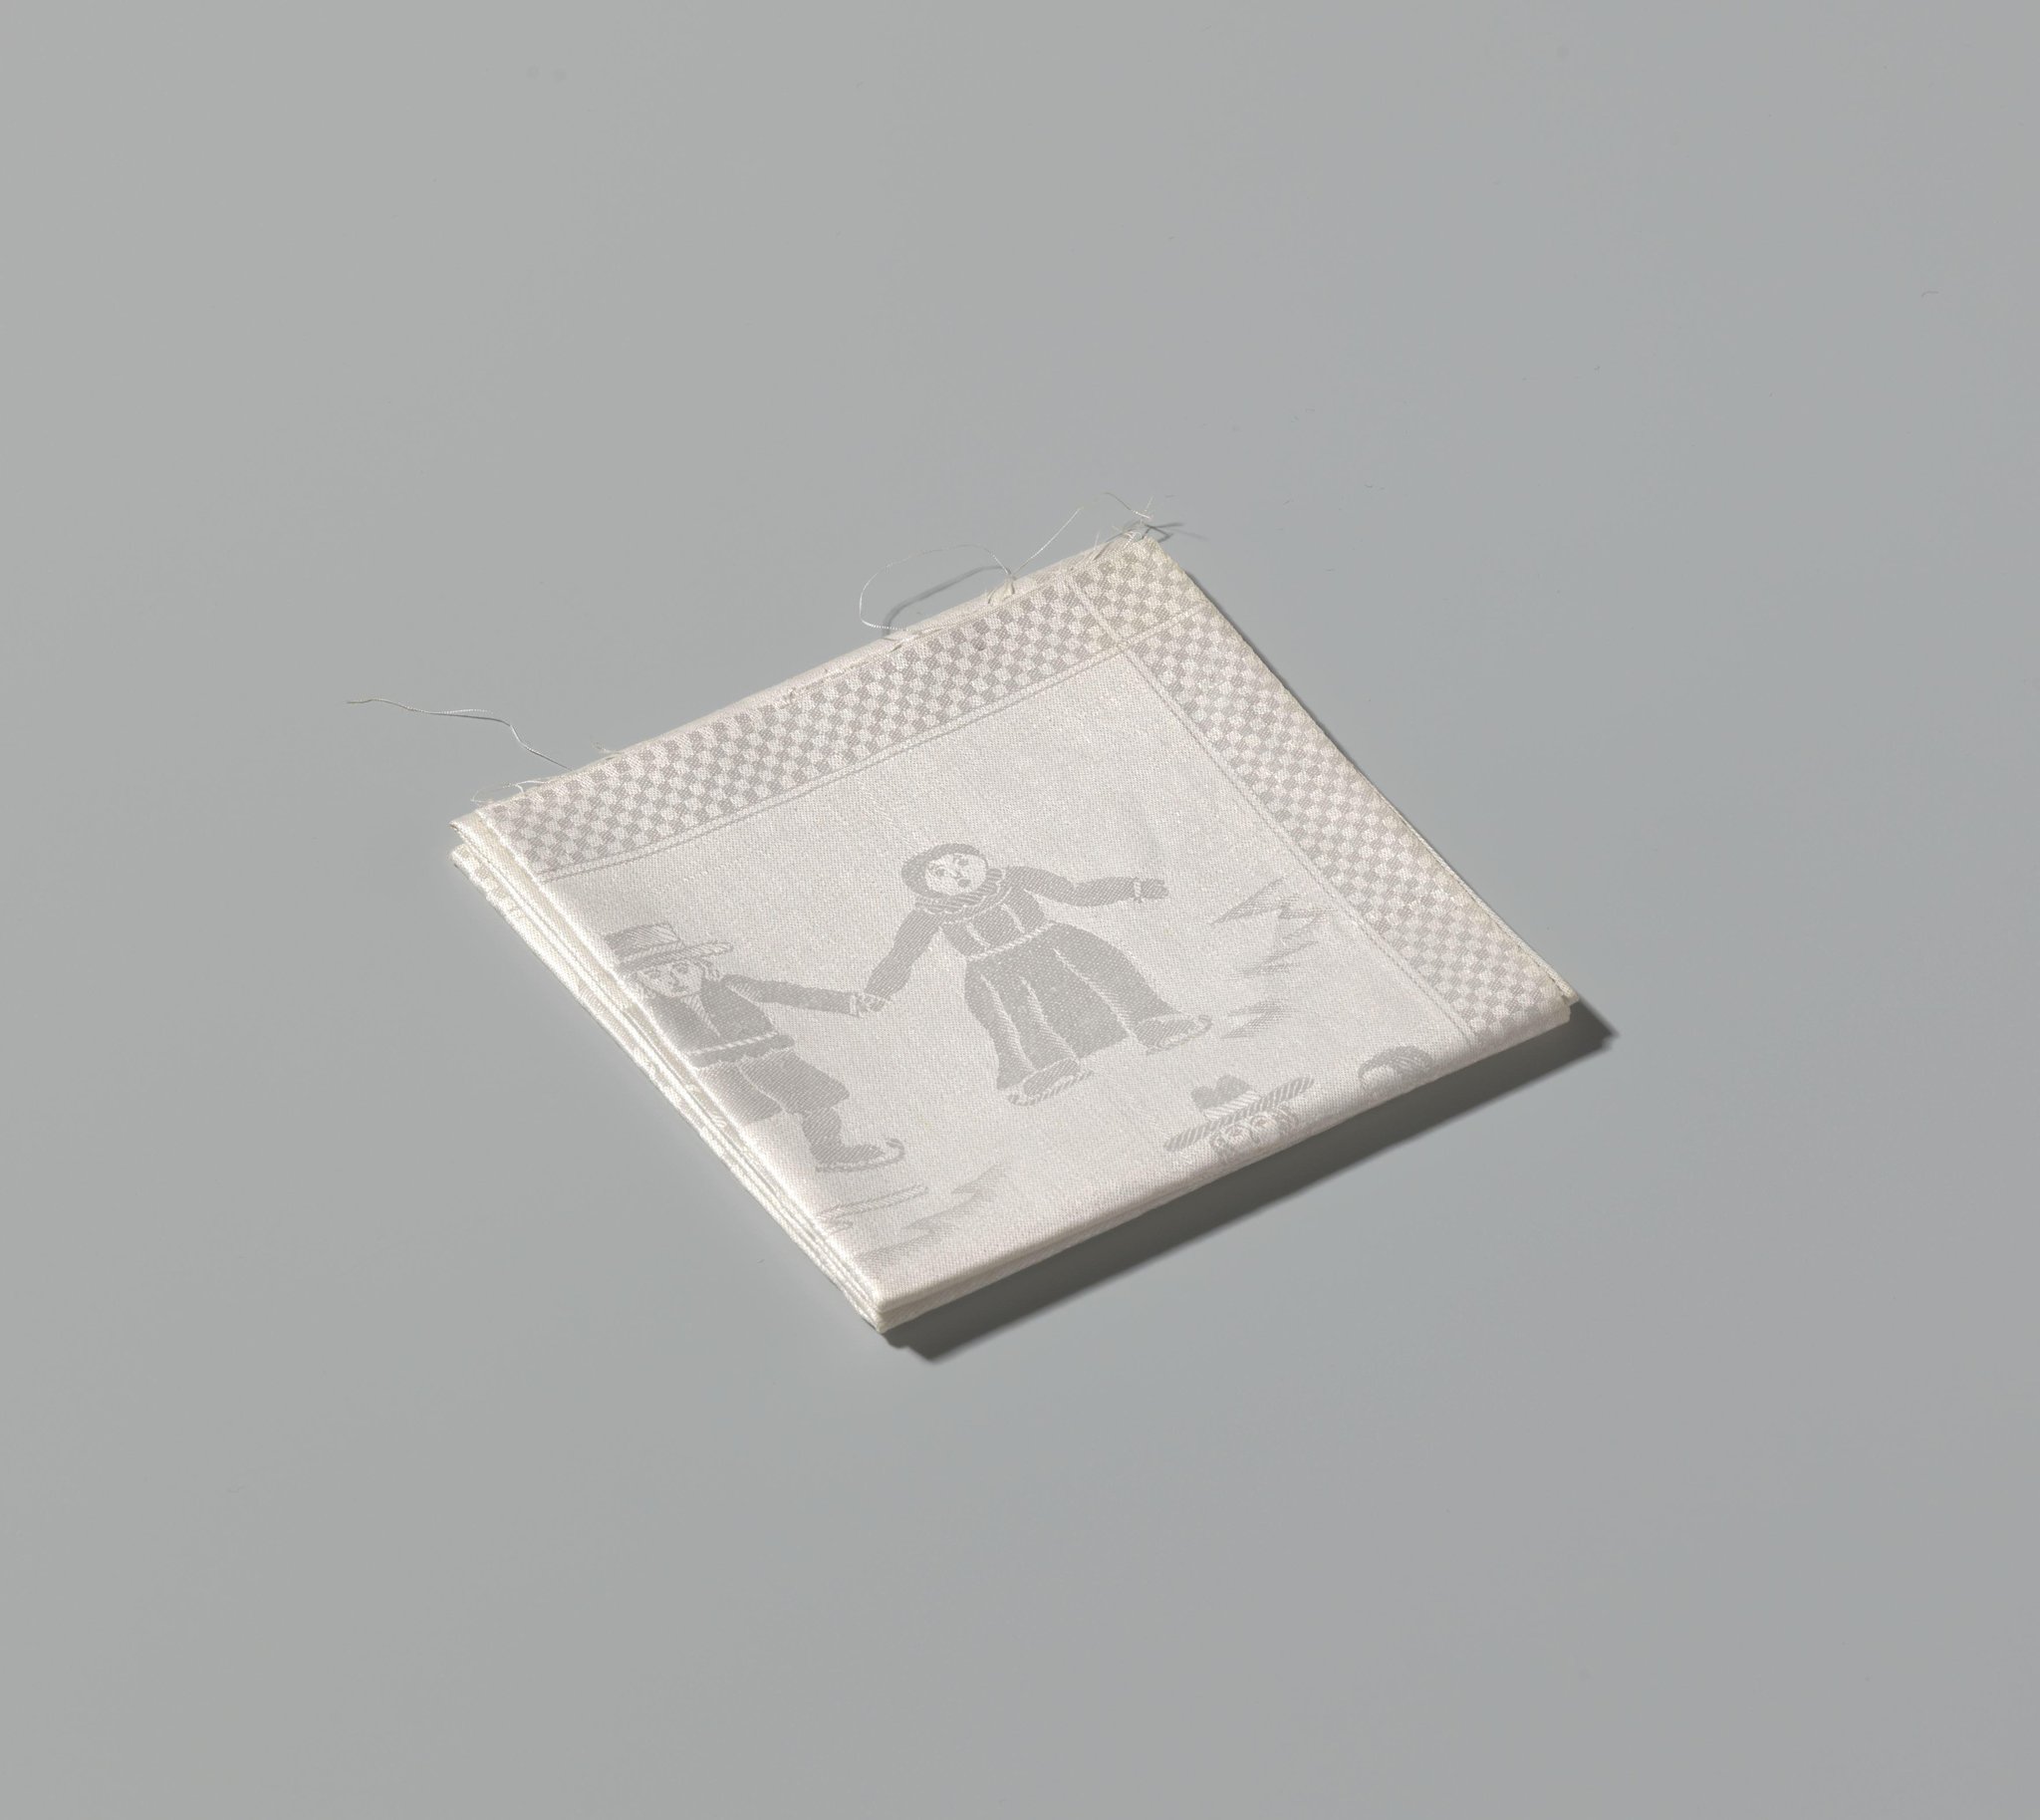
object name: napkin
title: Servet met scènes van ijsvermaak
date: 1933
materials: linen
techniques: damask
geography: haarlem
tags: winter landscape; landscape symbolizing winter (the four seasons of the year)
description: Servet van linnendamast met verschillende scènes van ijsvermaak, met in het midden een kale boom.